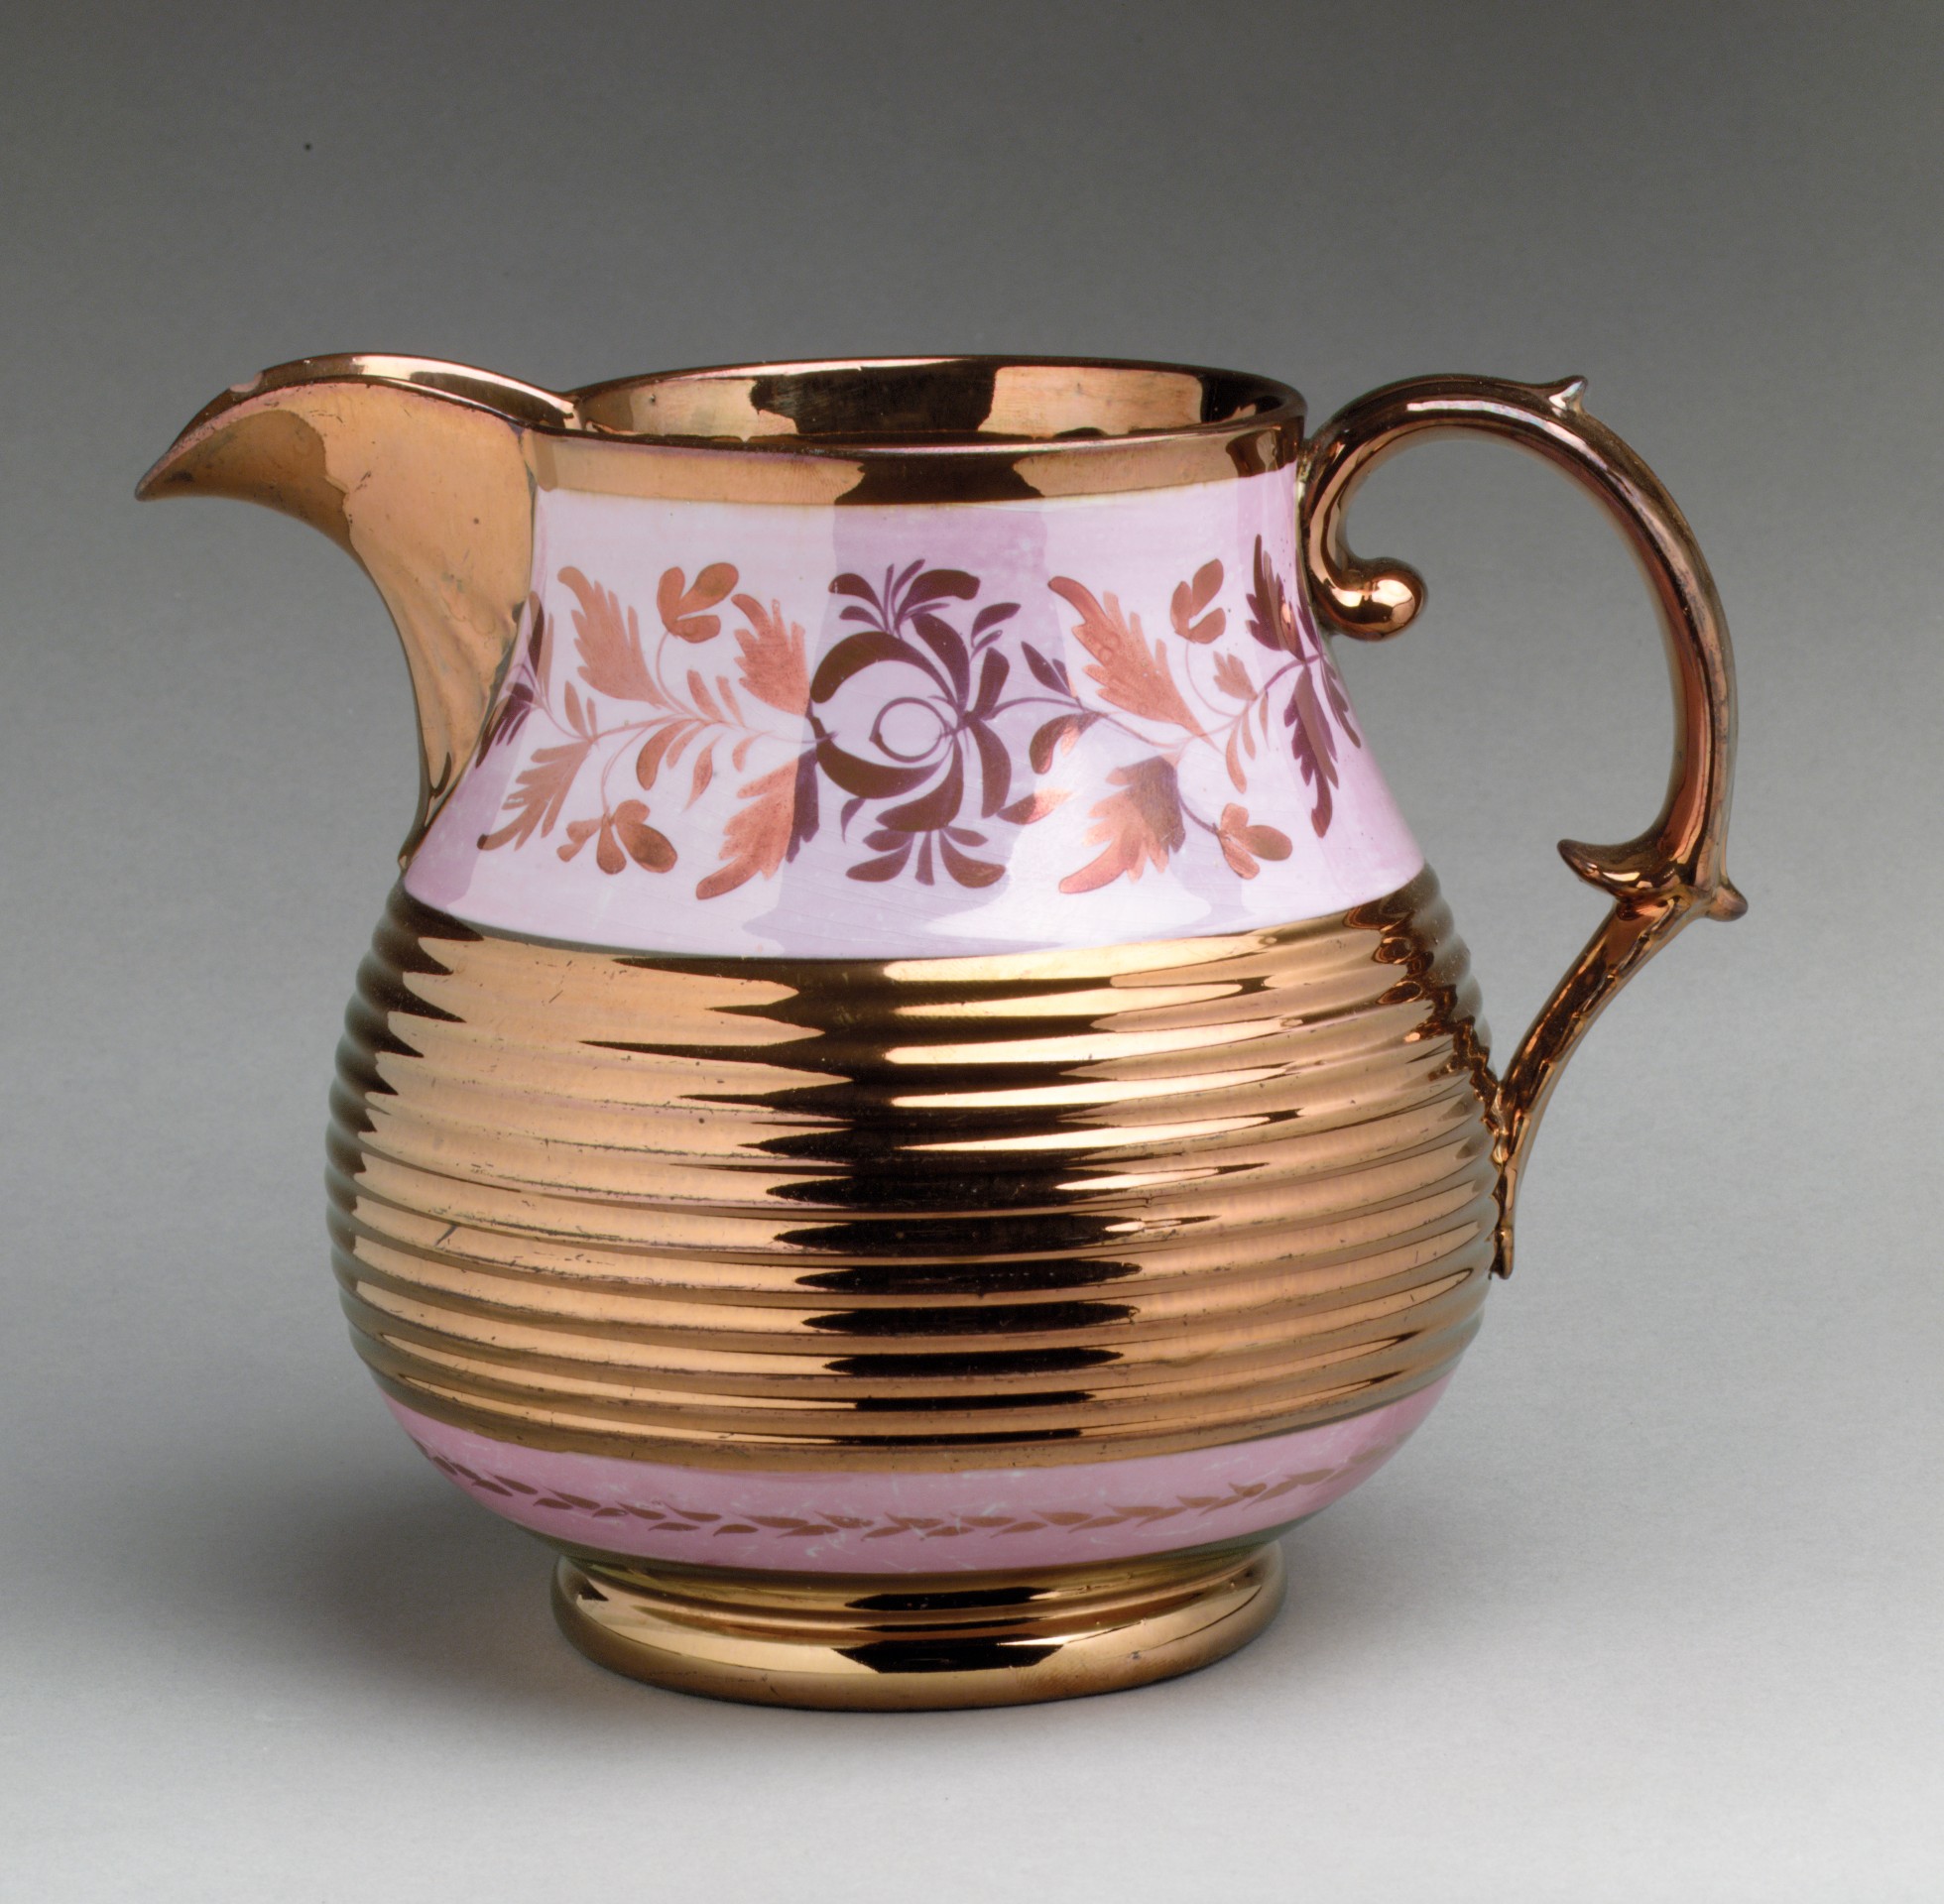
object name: jug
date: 1801-1900